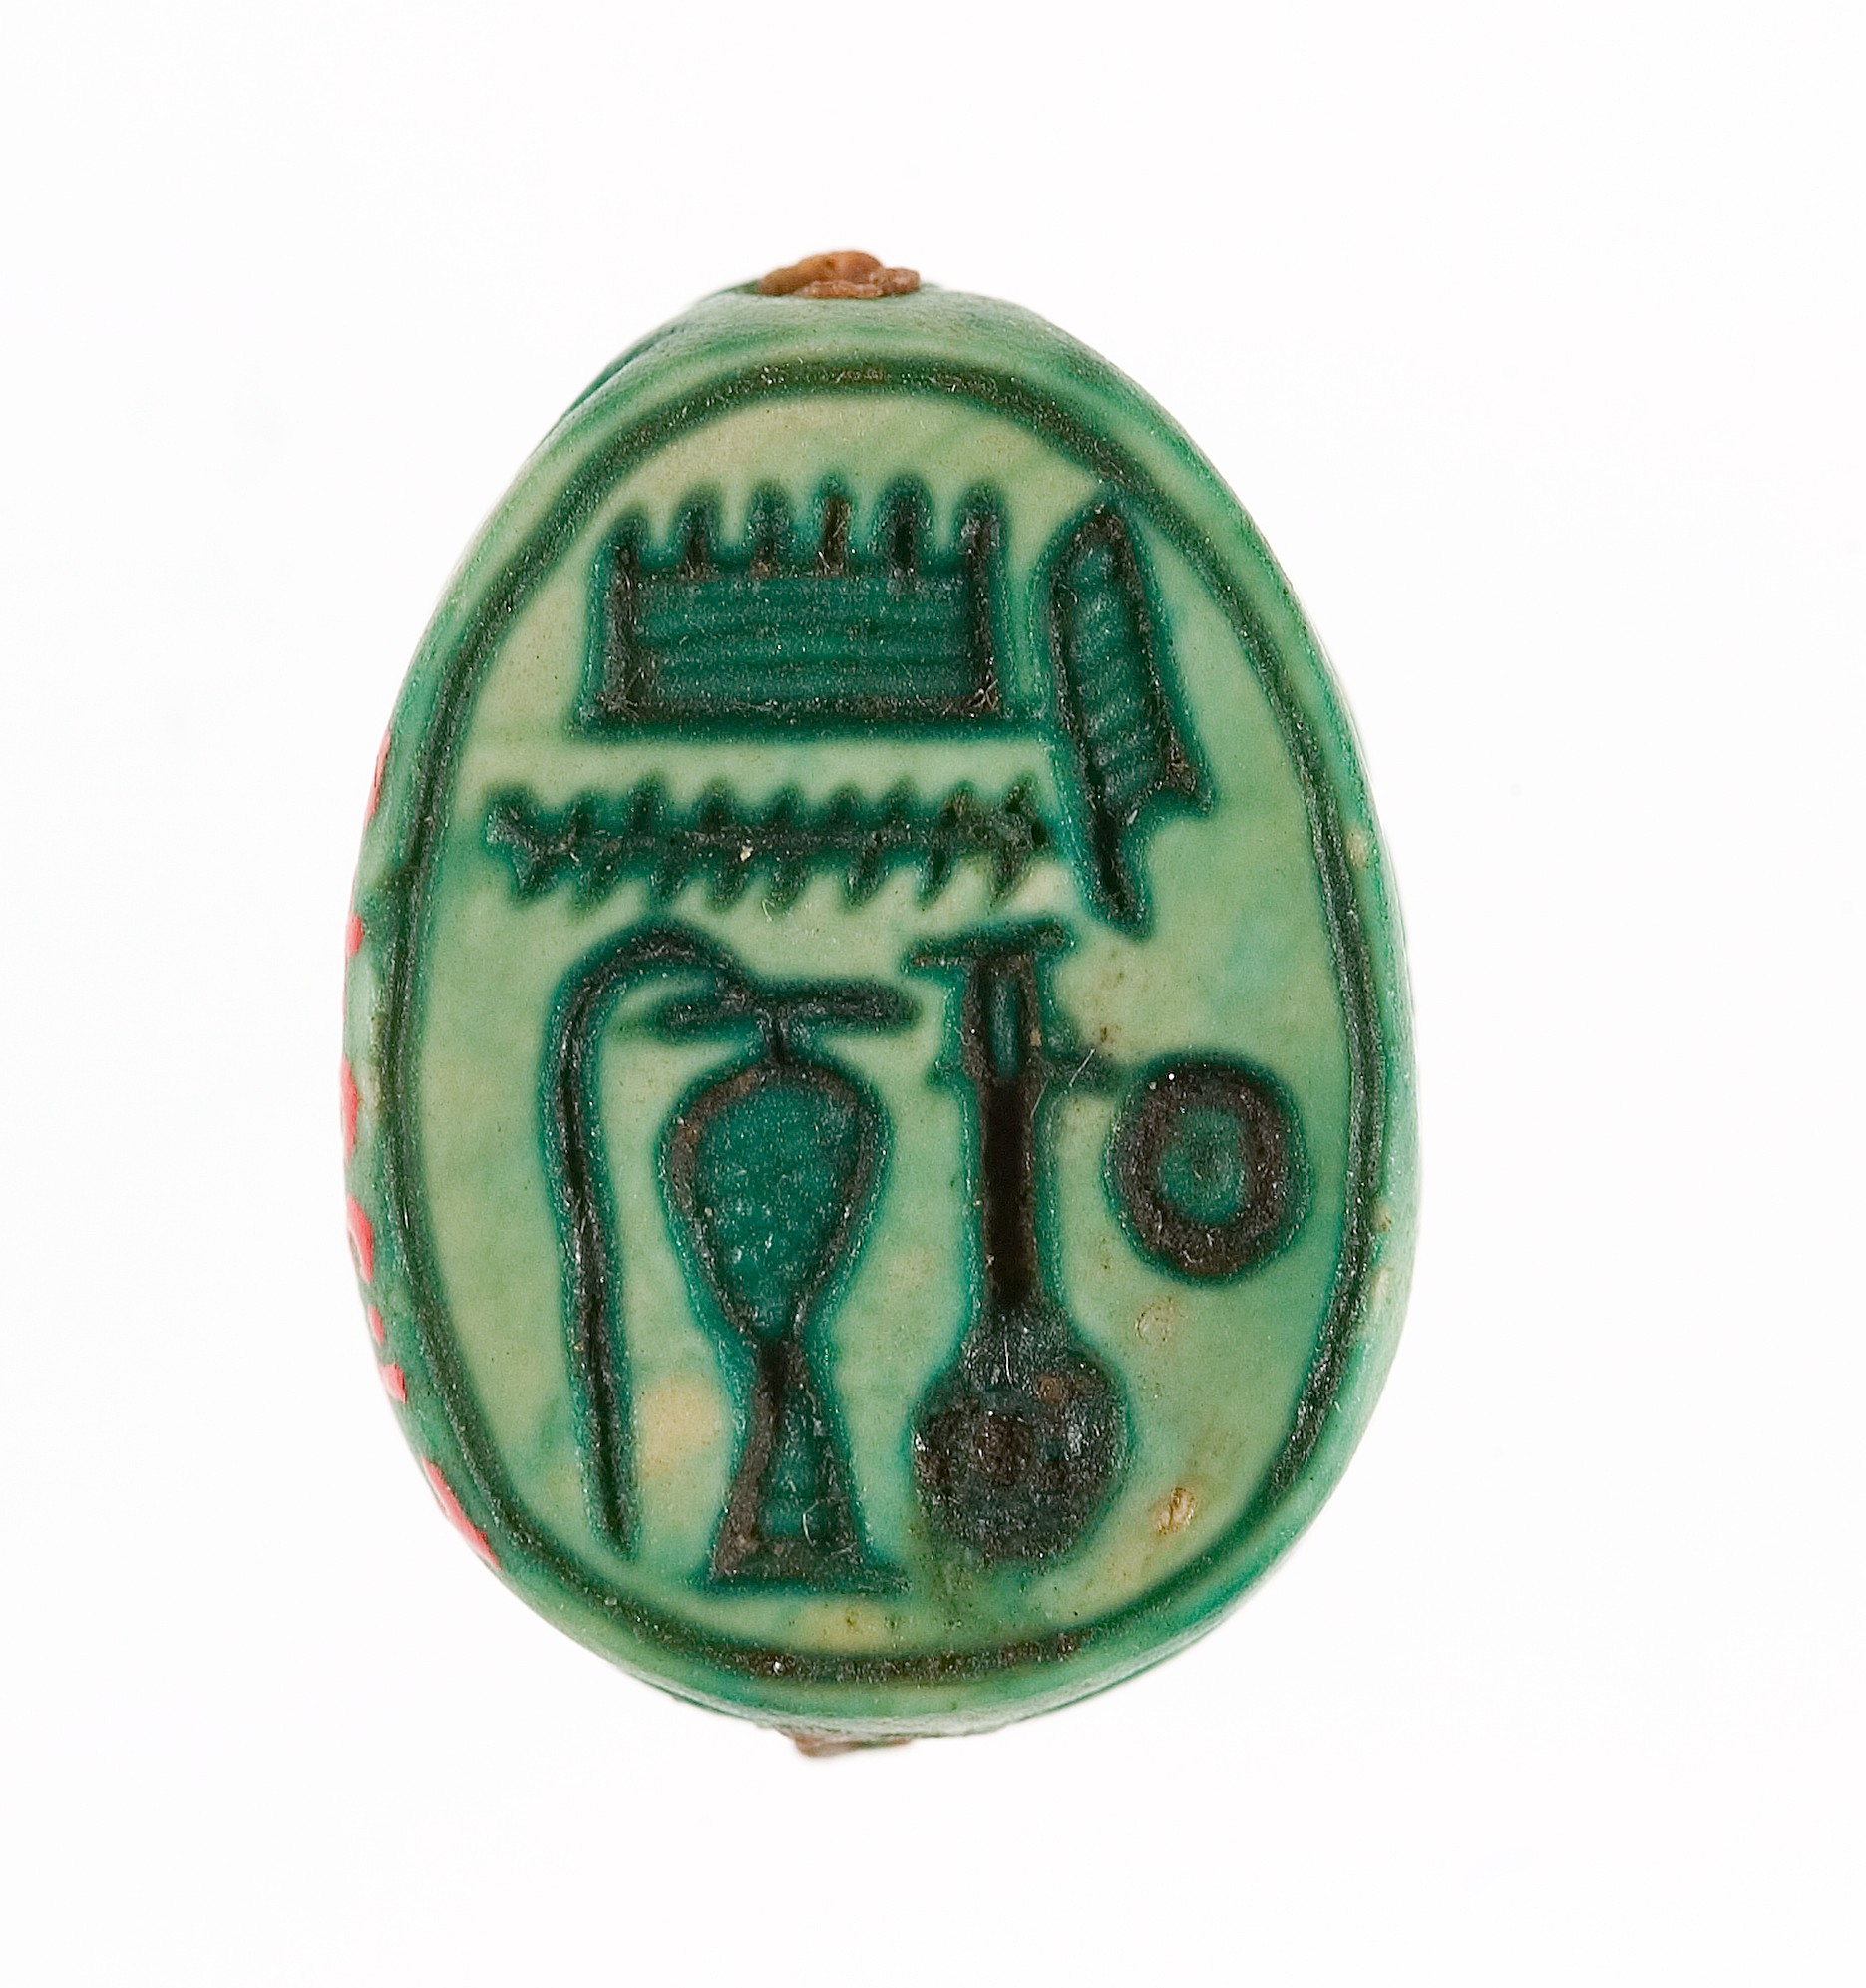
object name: scarab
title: Scarab Inscribed with the Name of the God Amun-Re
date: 1479-1458 BCE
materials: stone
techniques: glazing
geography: egypt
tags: hieroglyphs,scarabs